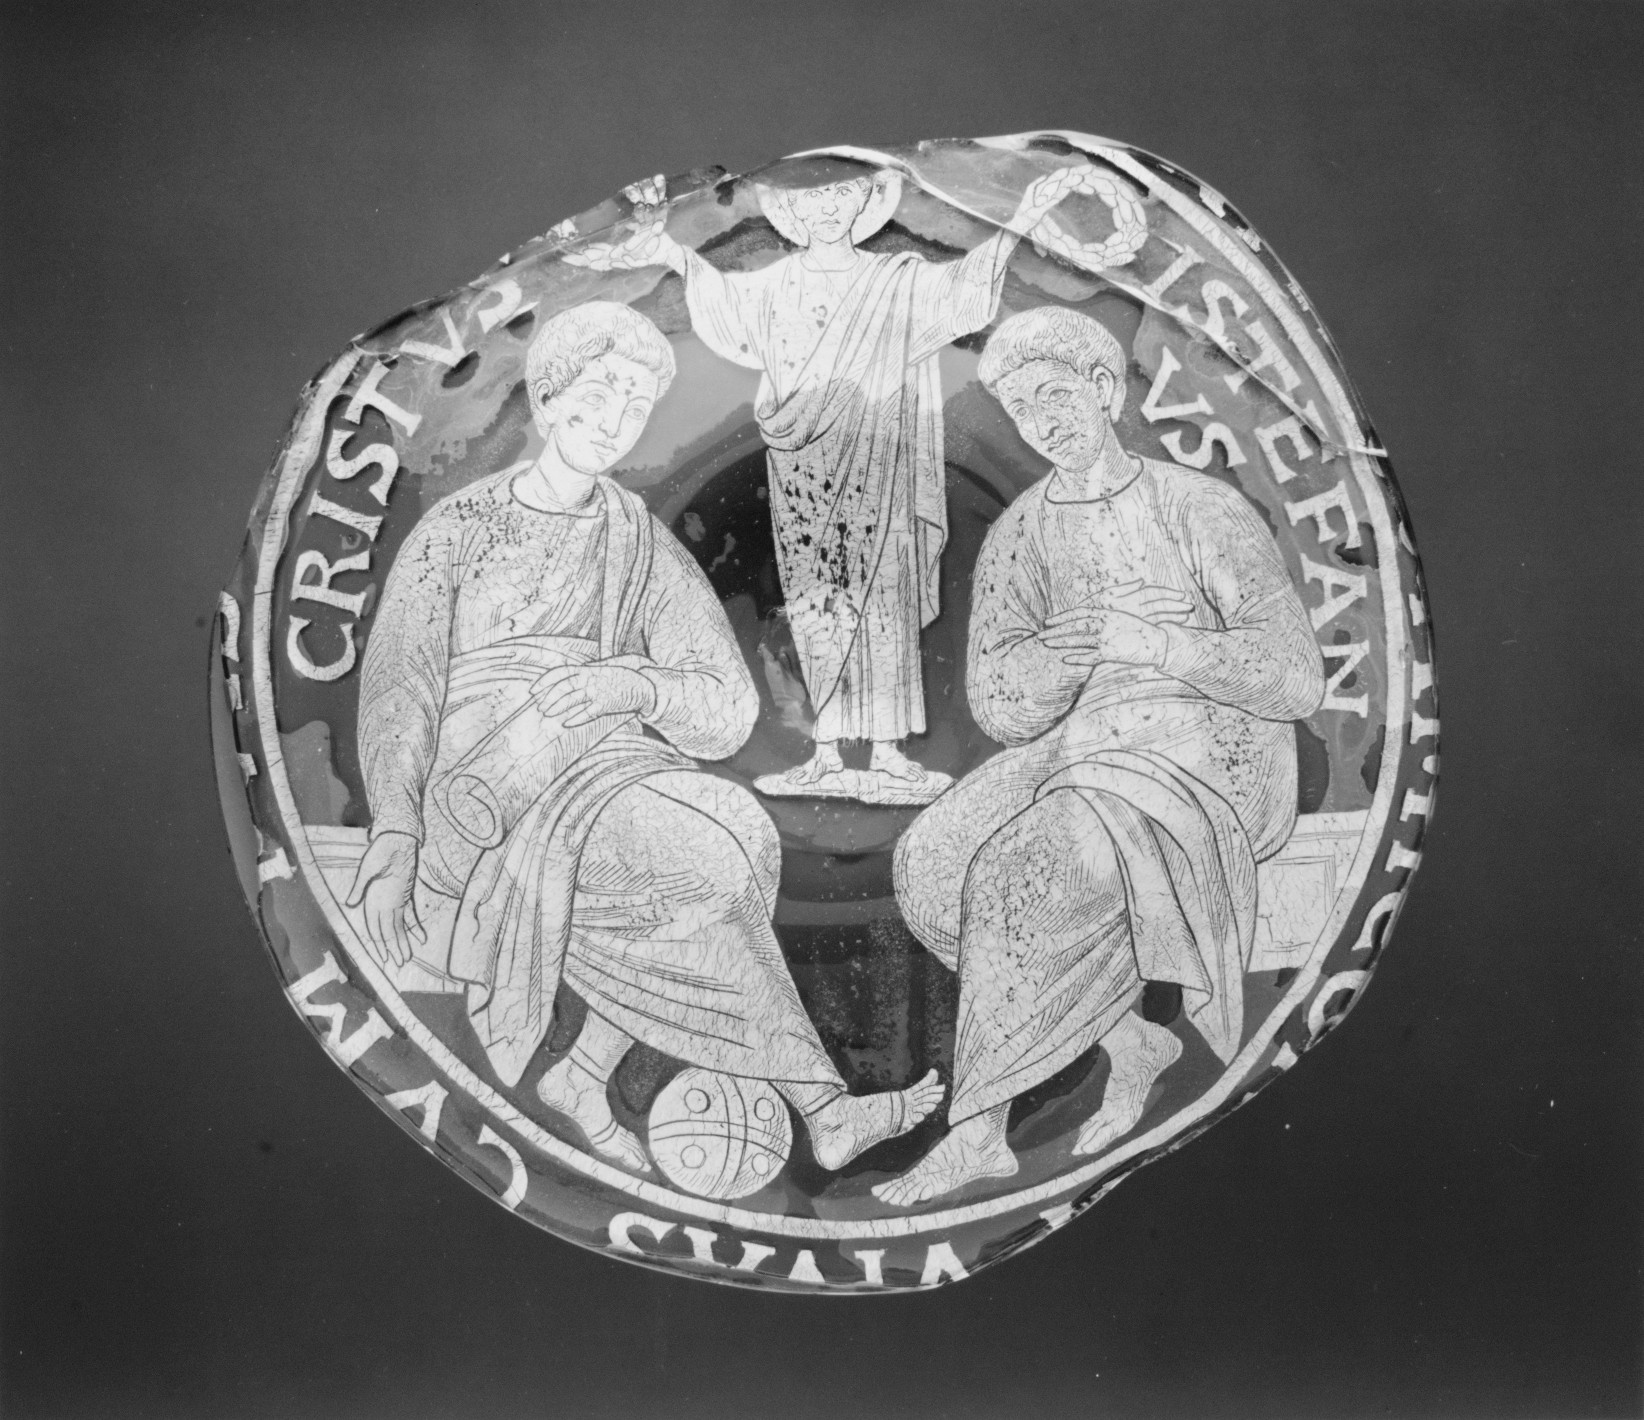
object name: plate fragment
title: Plate (fragment)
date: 1801-1900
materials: glass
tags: men,jesus